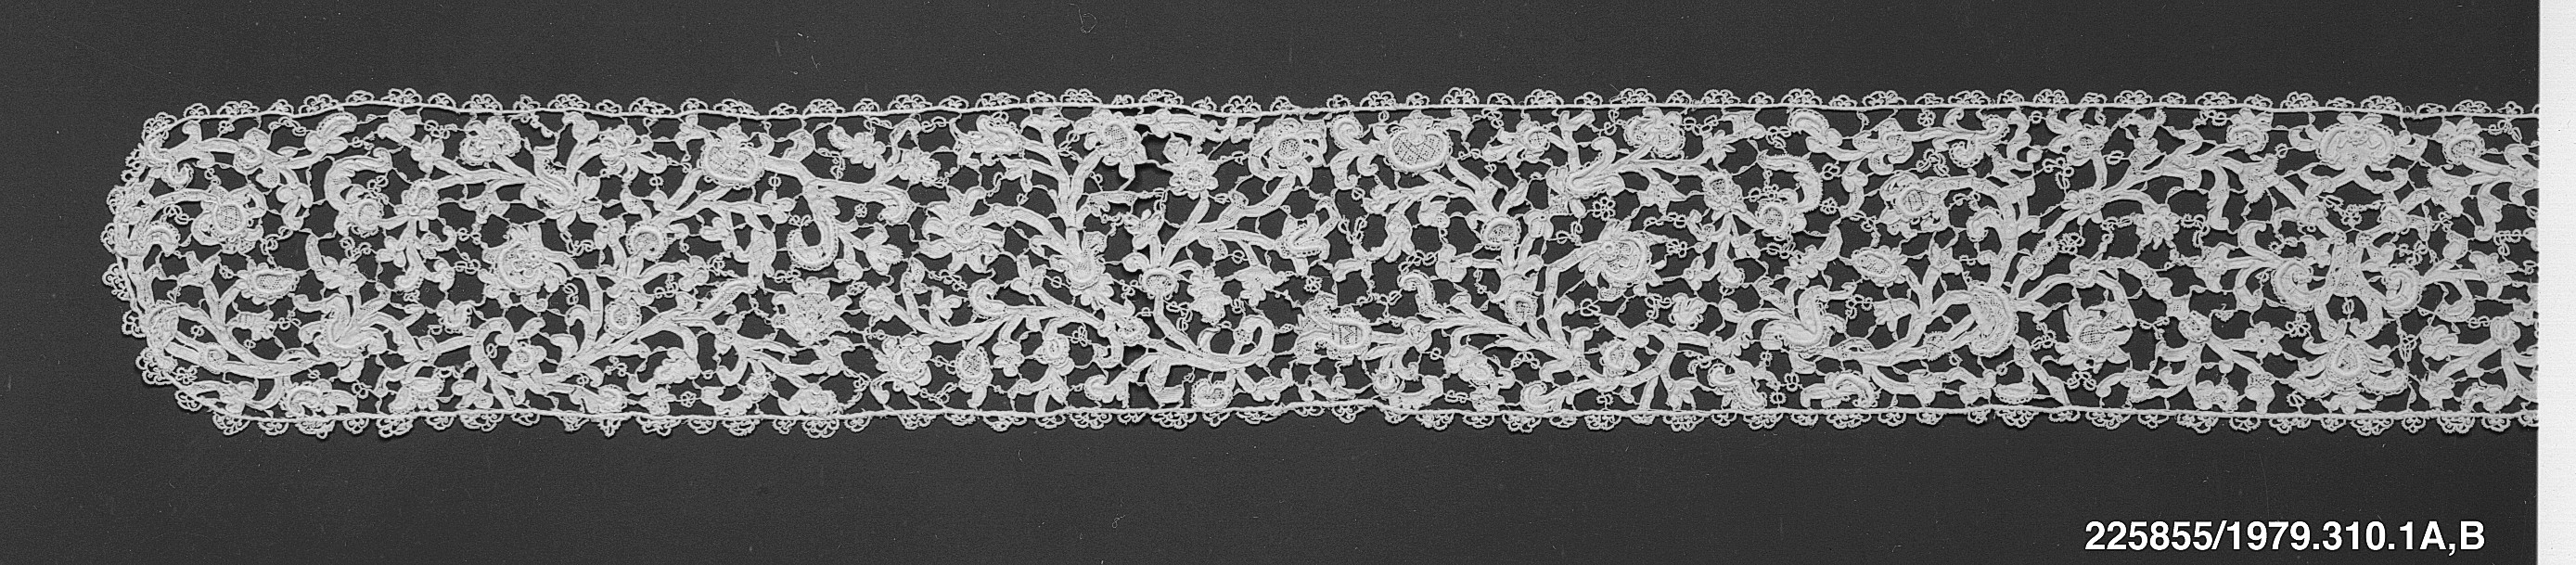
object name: lappet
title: Joined lappets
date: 1667-1700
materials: linen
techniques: lace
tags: flowers